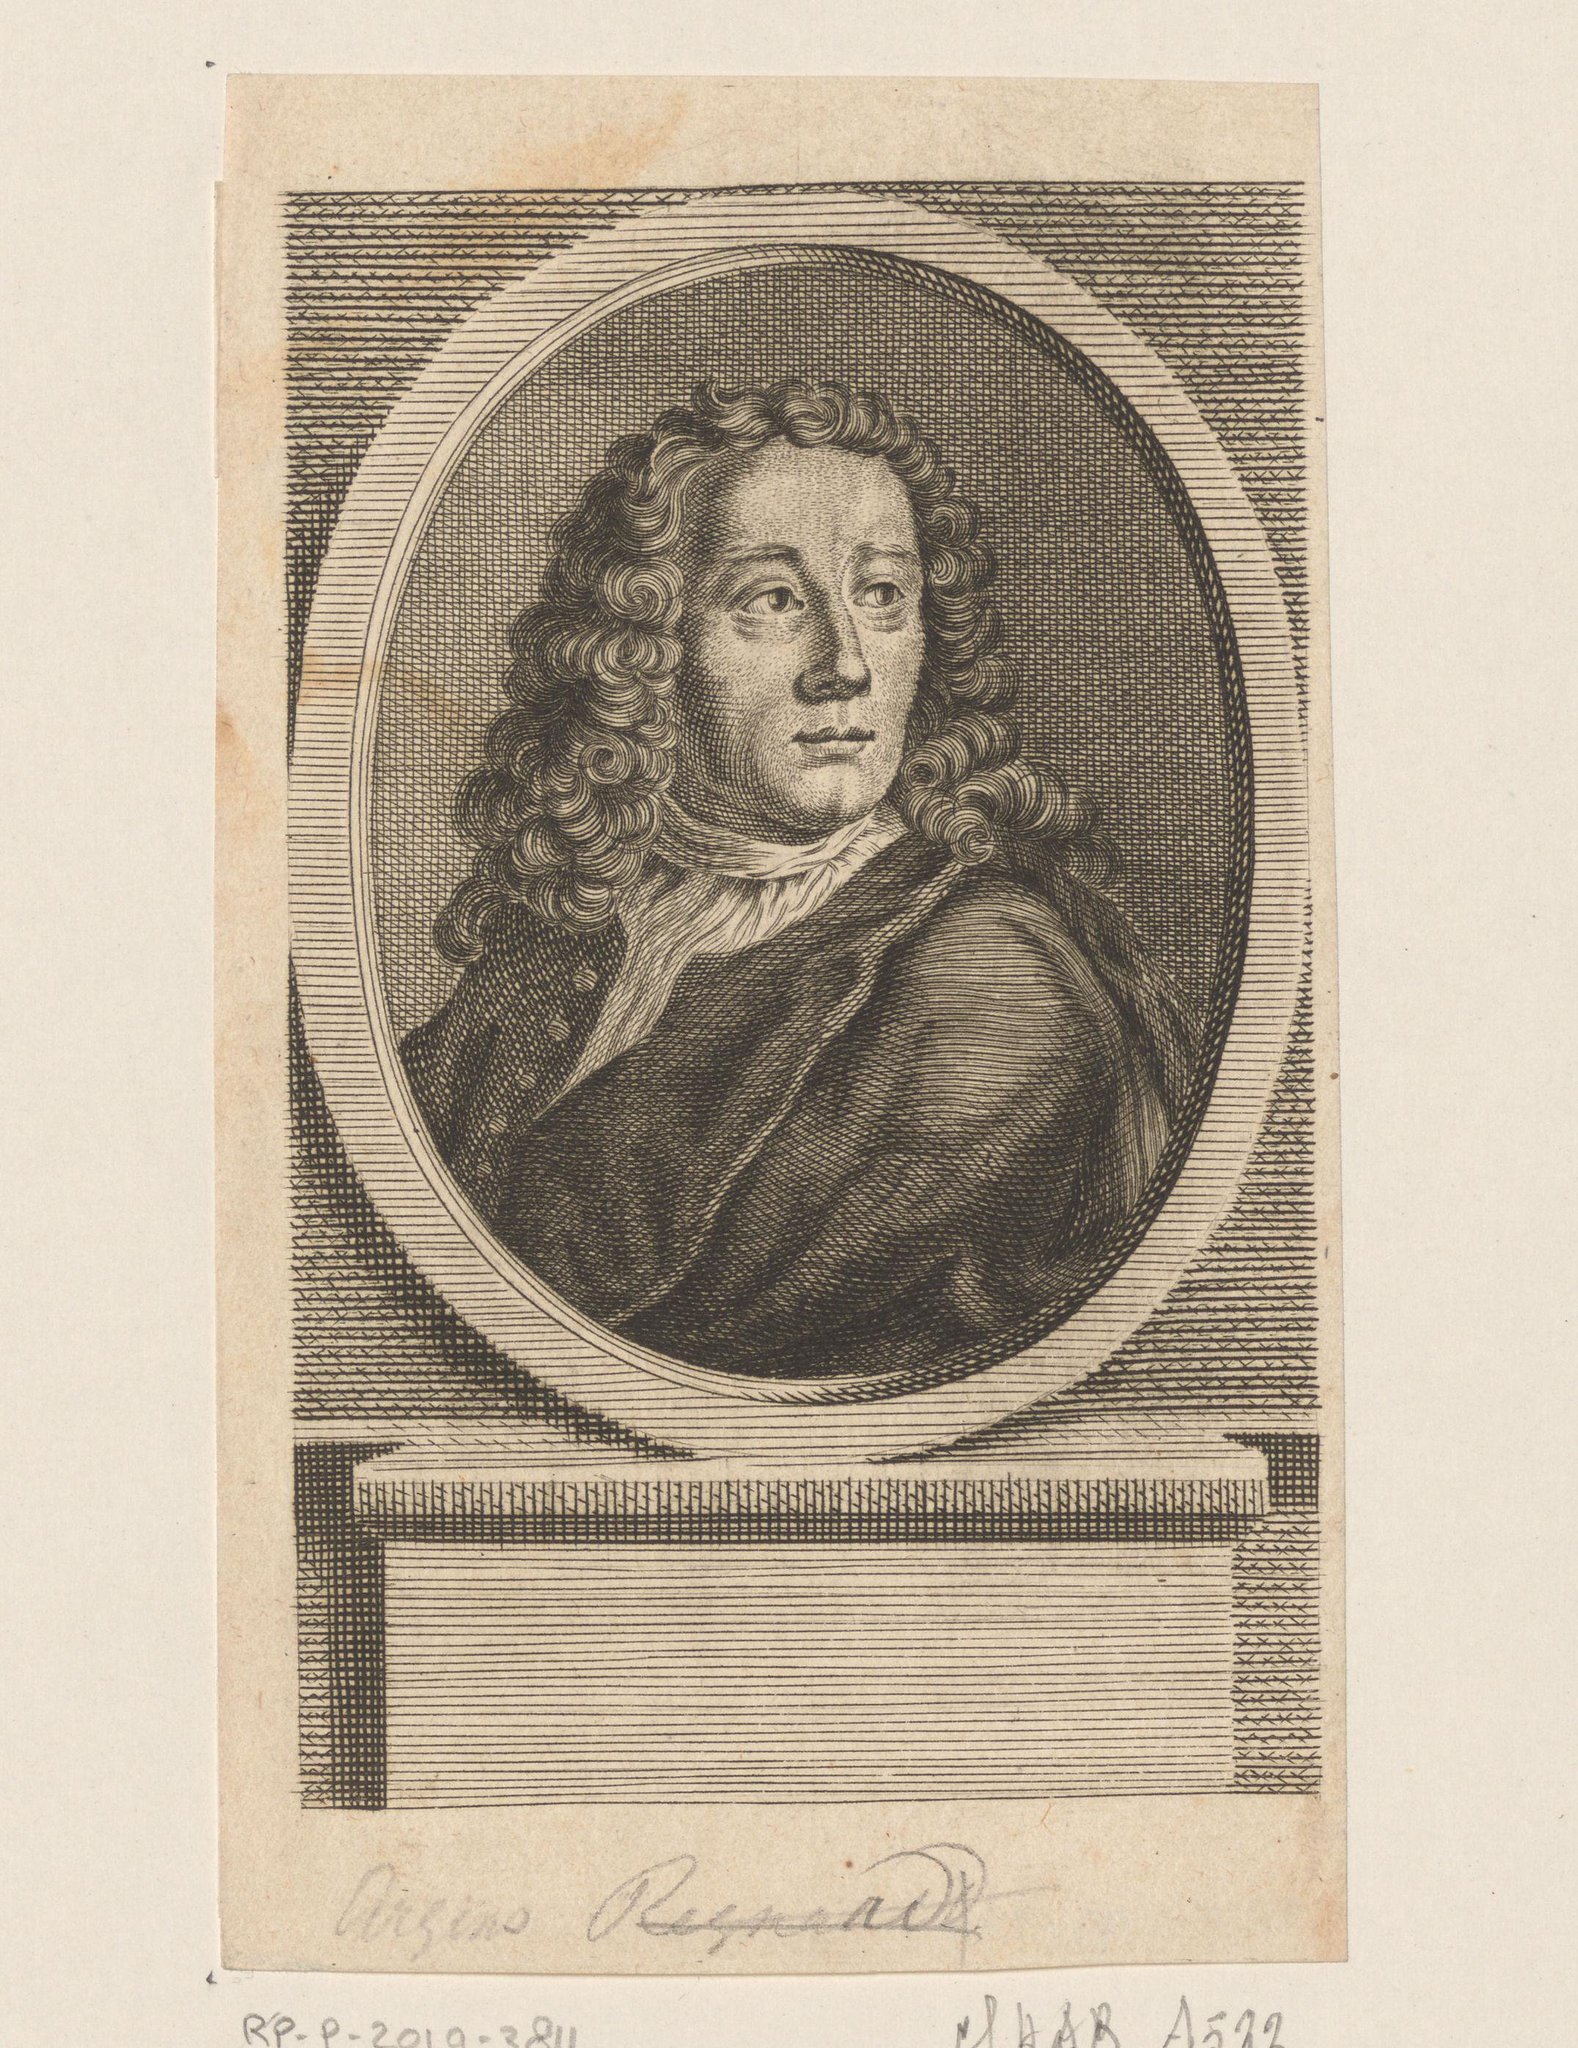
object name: print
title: Portret van Jean-Baptiste de Boyer, marquis d'Argens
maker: Anonymous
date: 1735-1780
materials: paper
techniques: engraving, etching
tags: toulon, historical persons, portrait of a writer